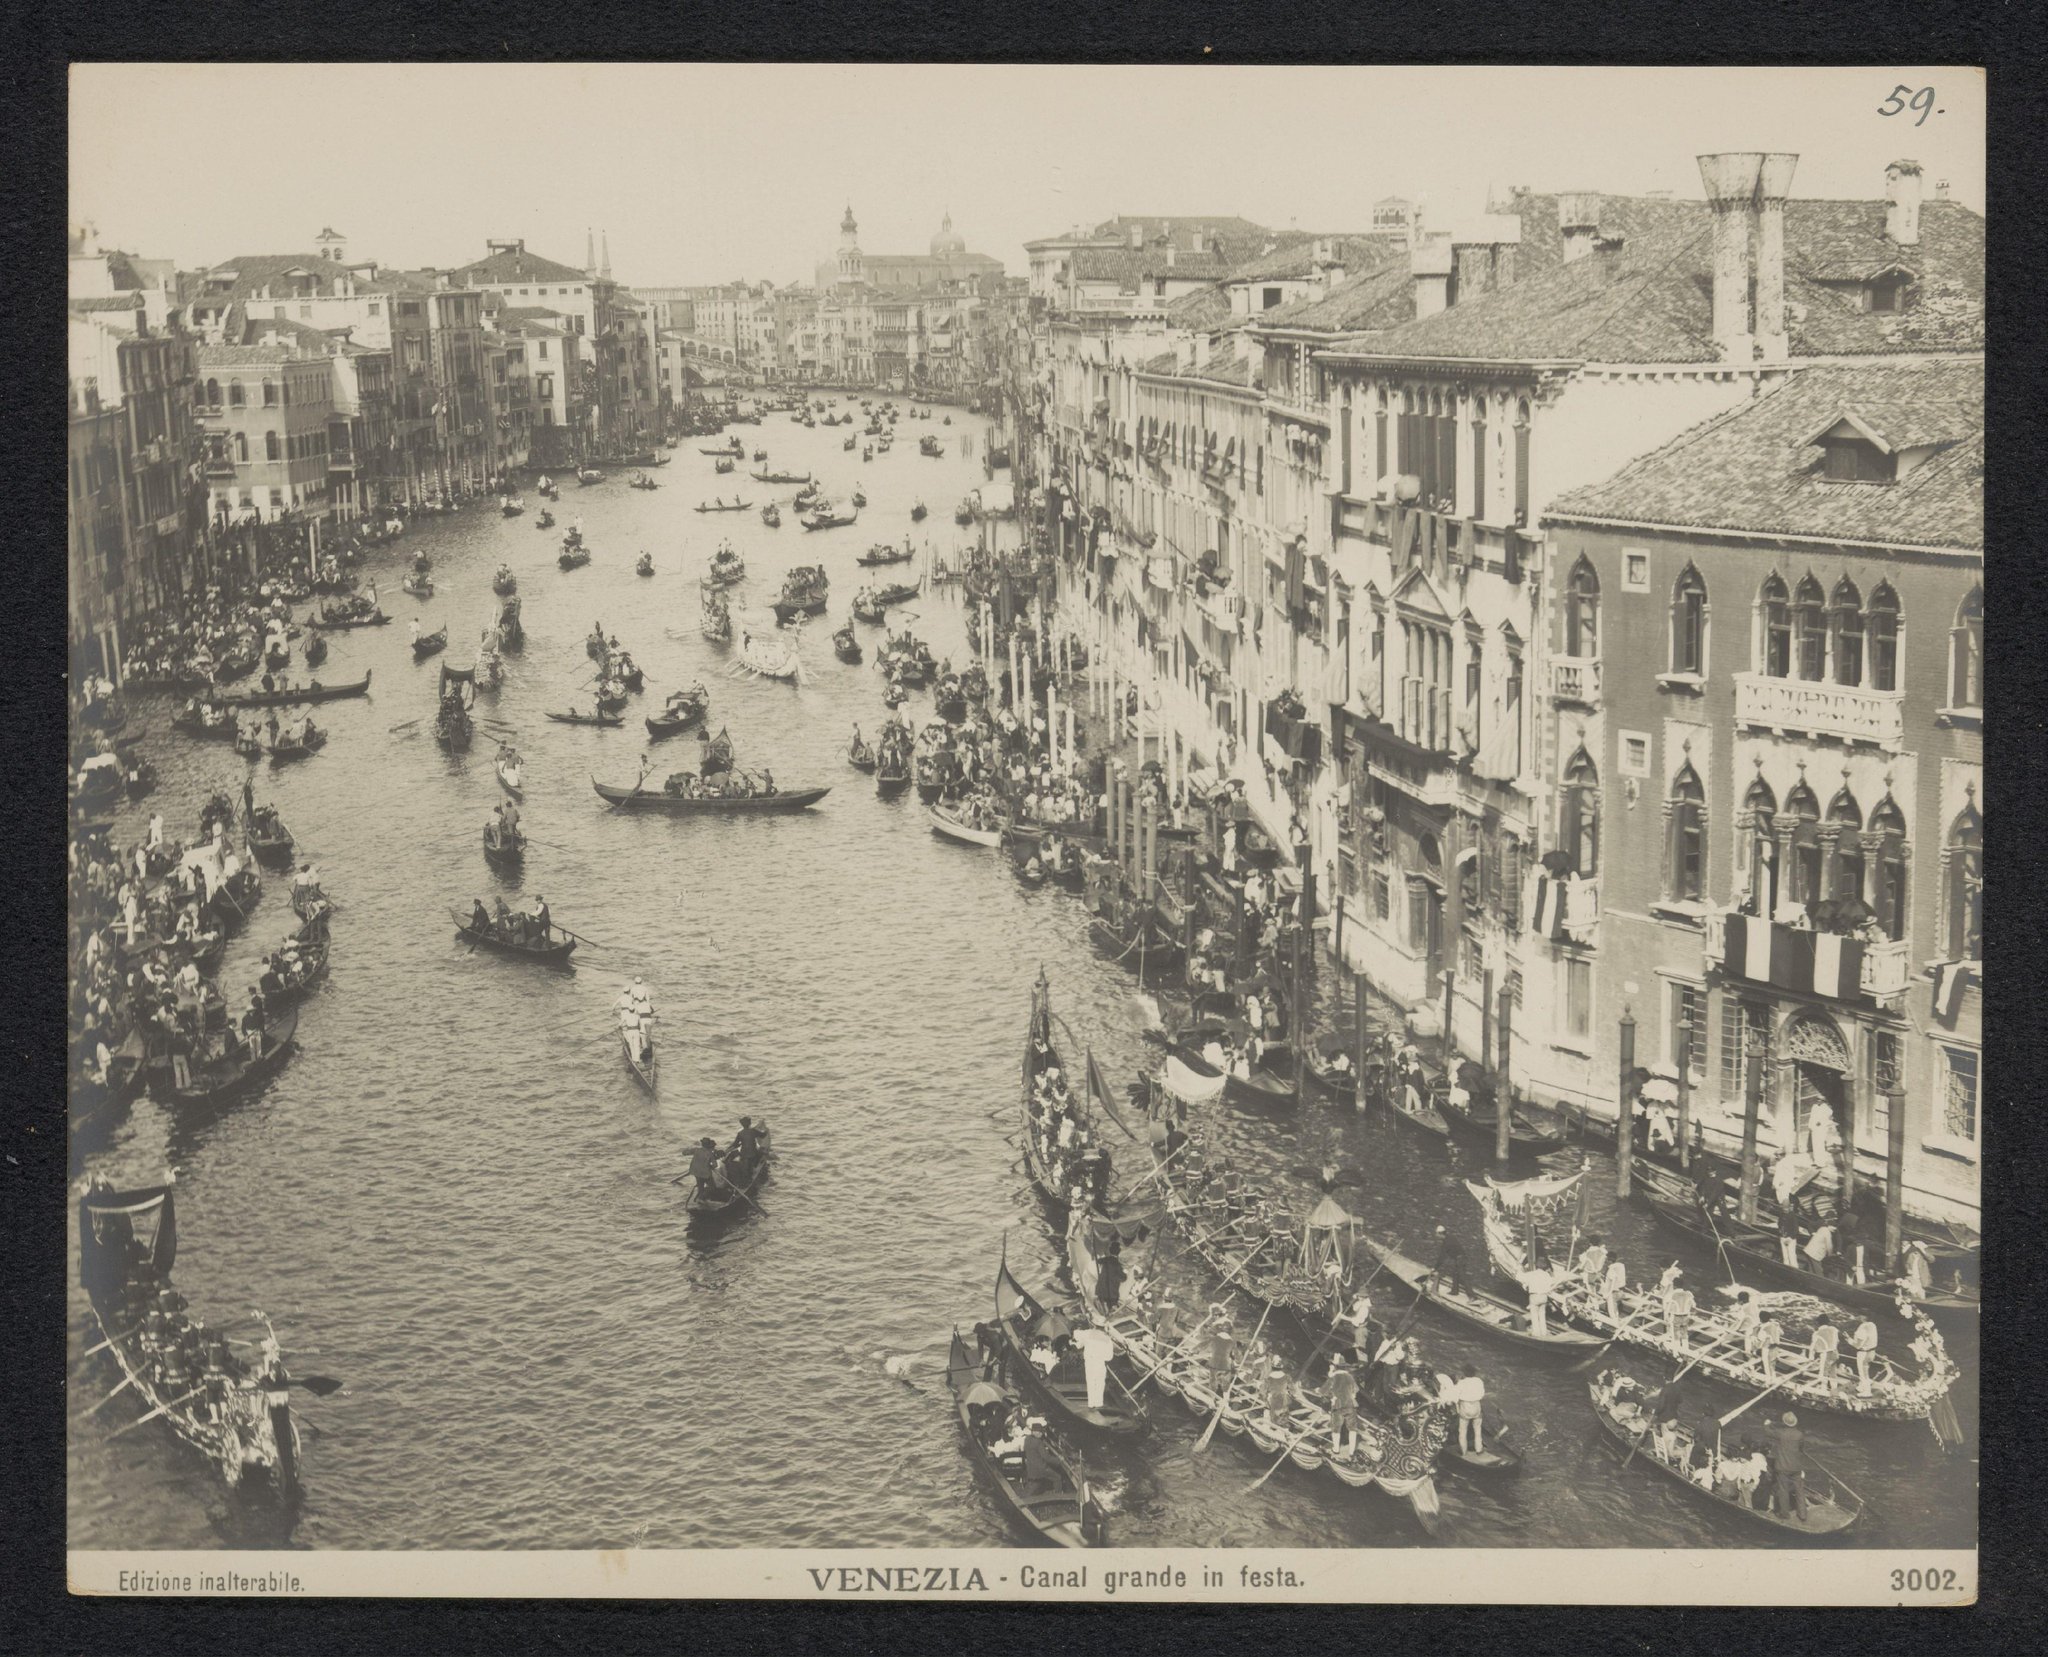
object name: photograph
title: Venezia. Canal grande in festa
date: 1900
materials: cardboard, photographic support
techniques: gelatin silver print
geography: venice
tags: canal, gondola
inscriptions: number: ‘3002’, number: ‘59.’